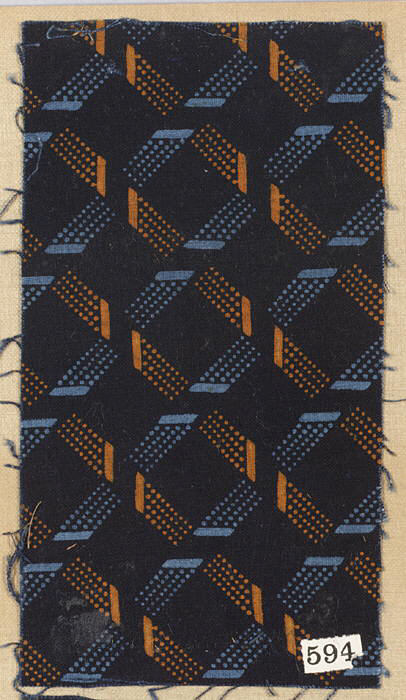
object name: piece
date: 1801-1900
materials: cotton